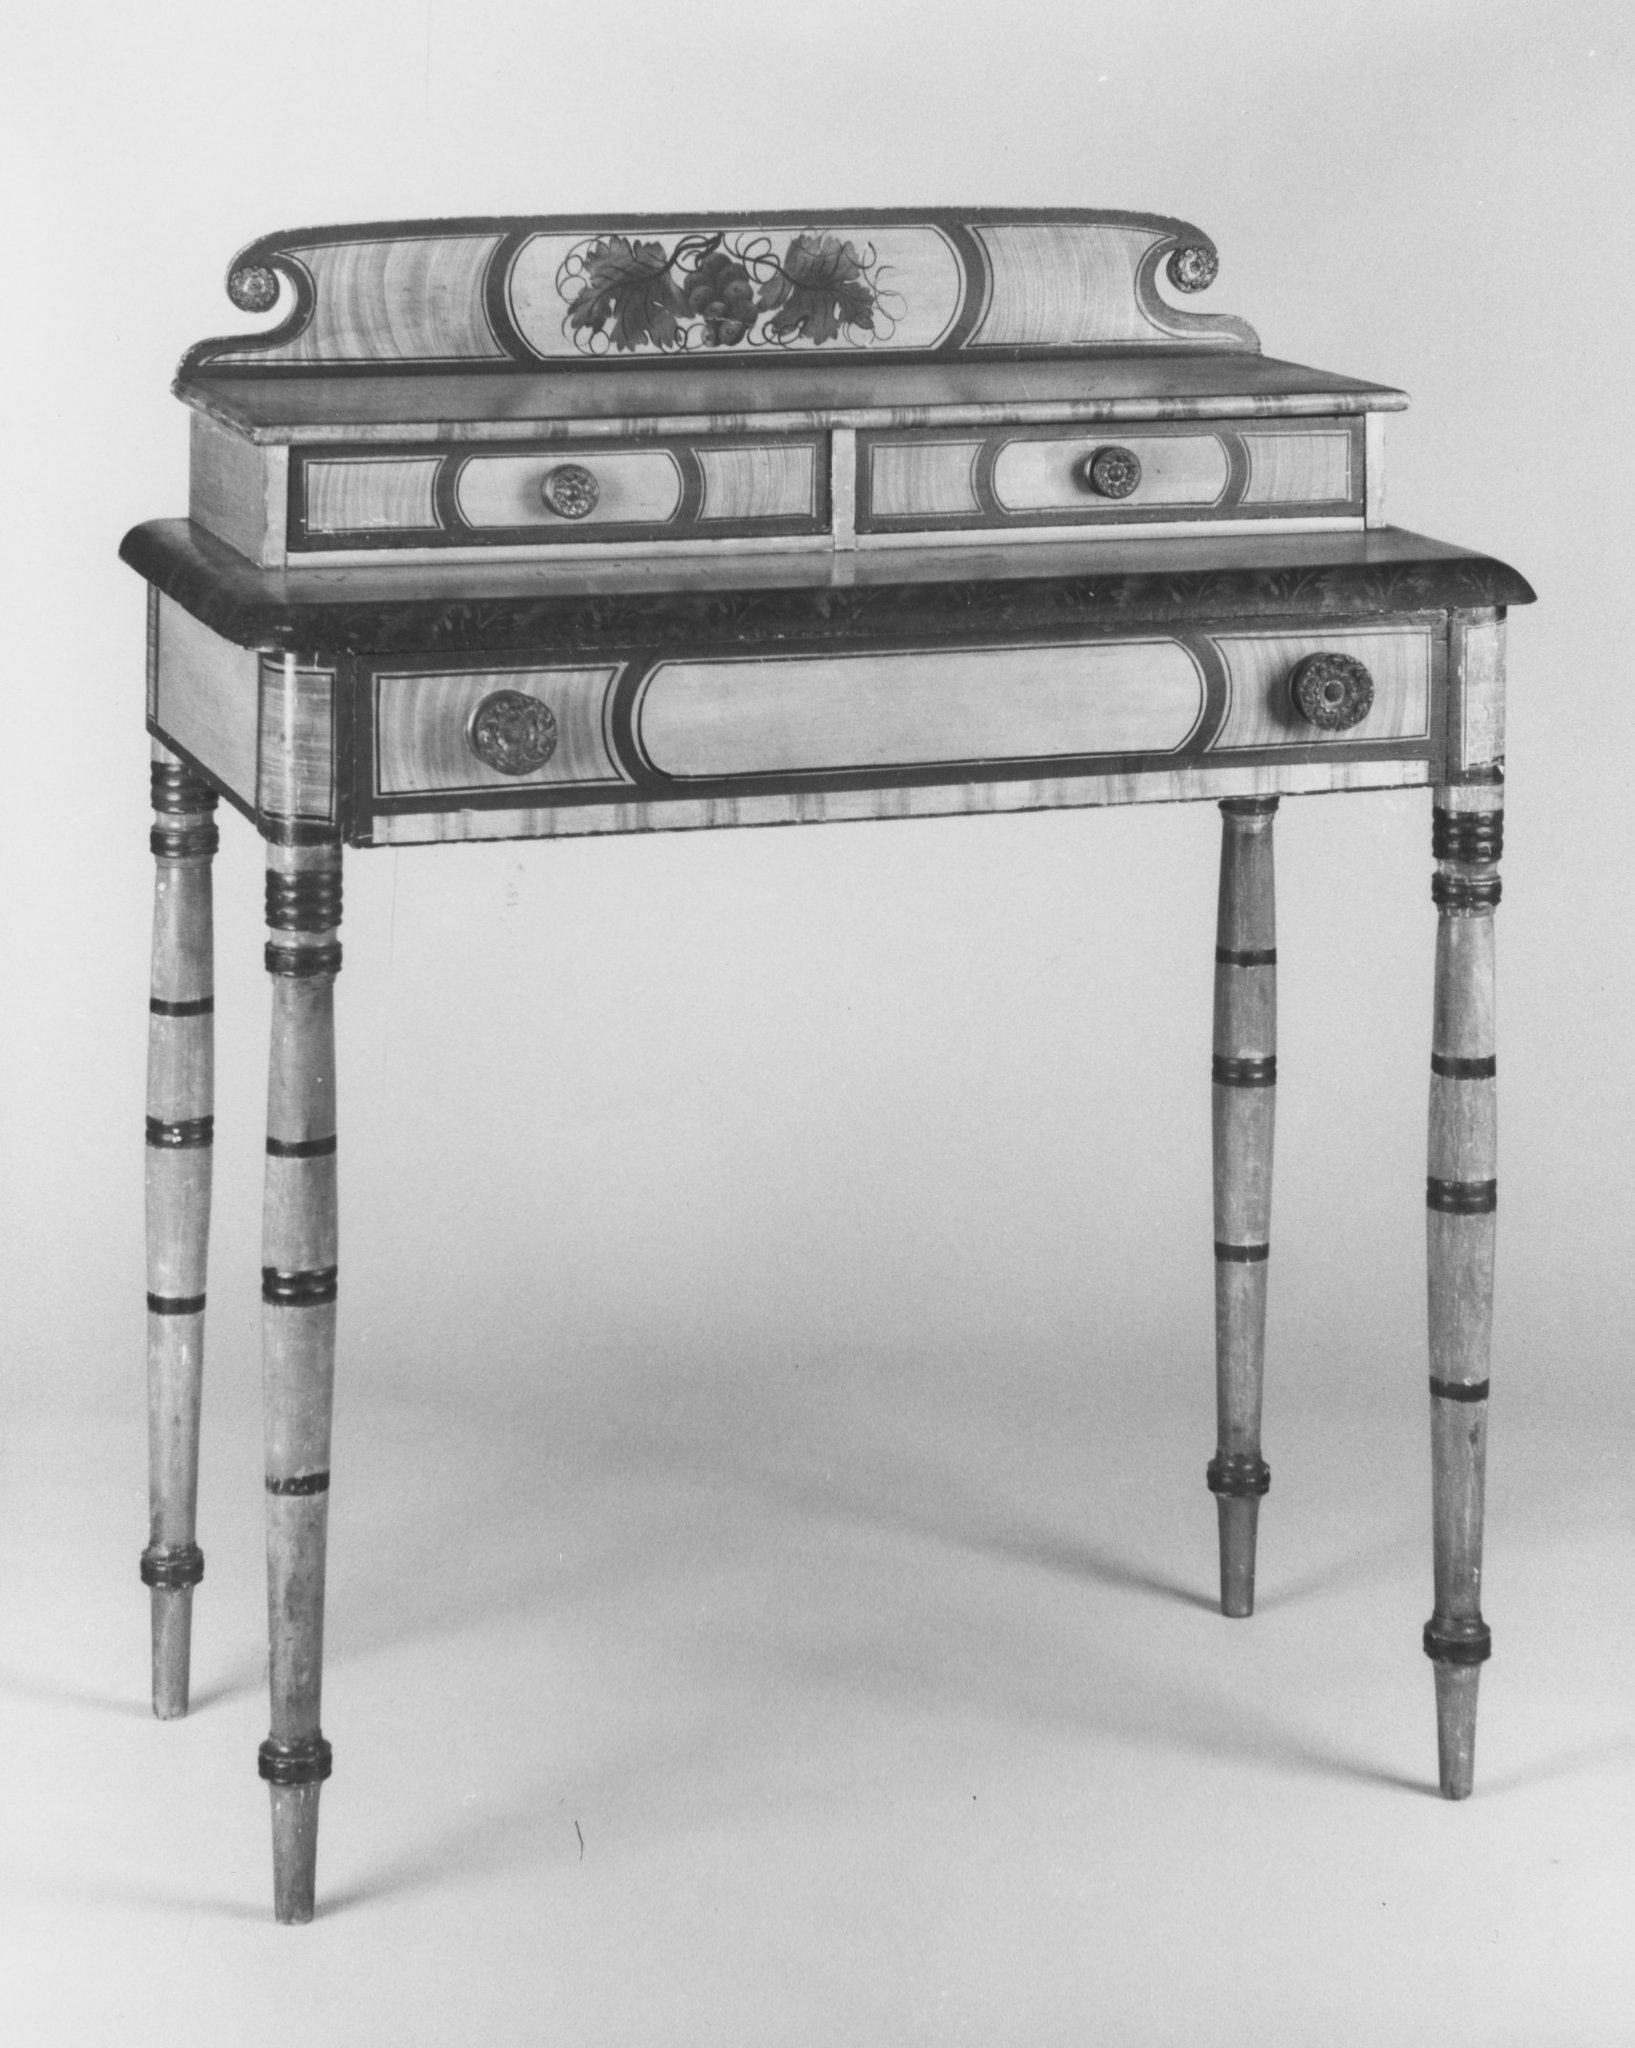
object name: dressing table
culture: american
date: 1820-1840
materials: wood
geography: united states